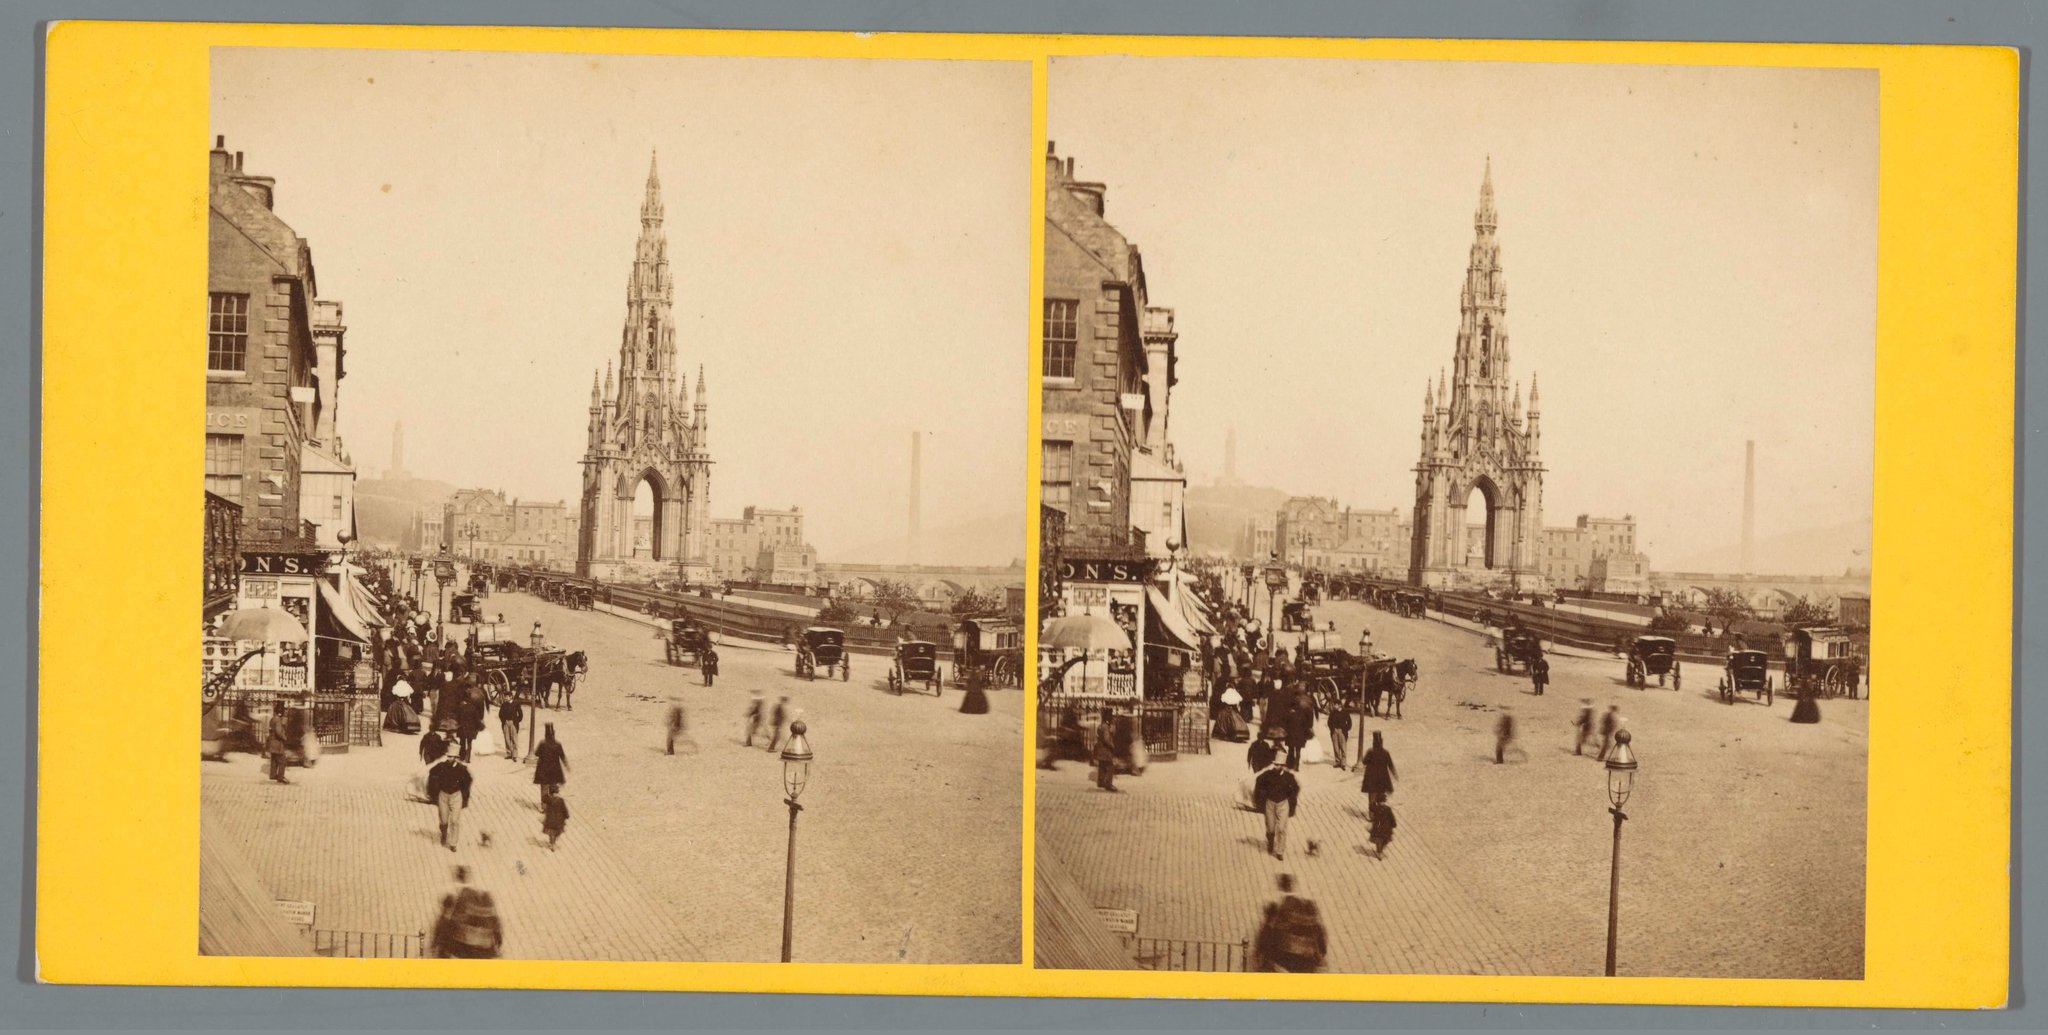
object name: stereograph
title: A. Scott’s Monument, Edinburgh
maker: george washington wilson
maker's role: publisher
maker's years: 1823-1893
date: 1860-1865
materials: cardboard, photographic support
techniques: albumen print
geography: aberdeen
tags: schotland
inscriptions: label: ‘G.W. Wilson & Co, Aberdeen No. 114 A. Scott’s Monument, Edinburgh’